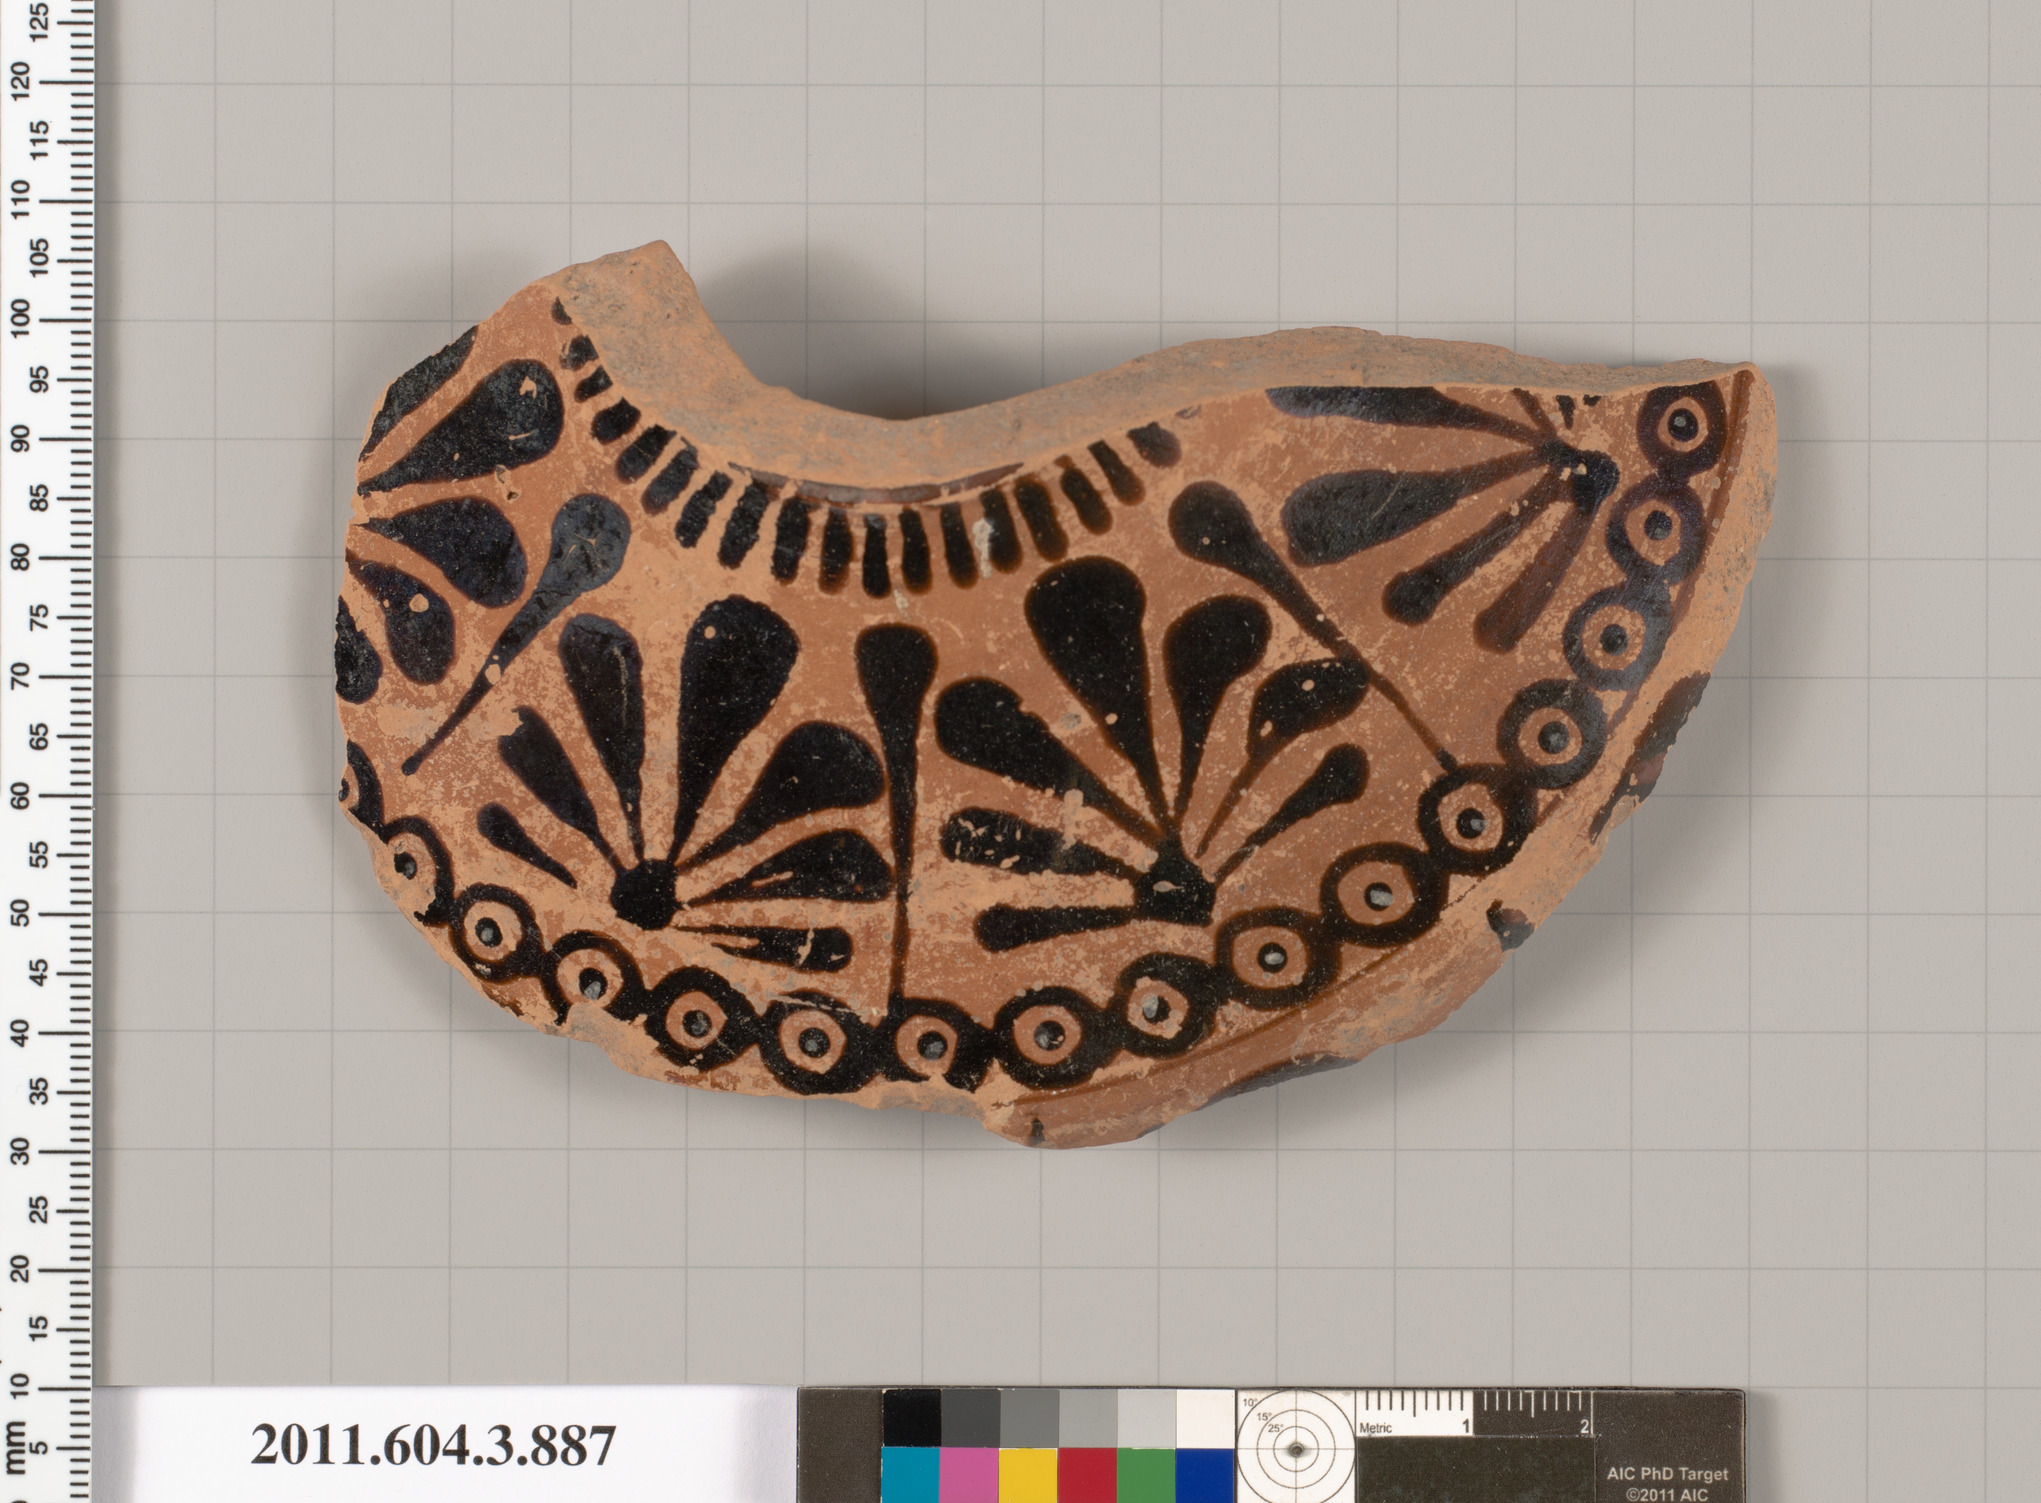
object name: lekythos fragment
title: Terracotta fragment of a lekythos (oil flask)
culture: greek, attic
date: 534-468 BCE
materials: terracotta